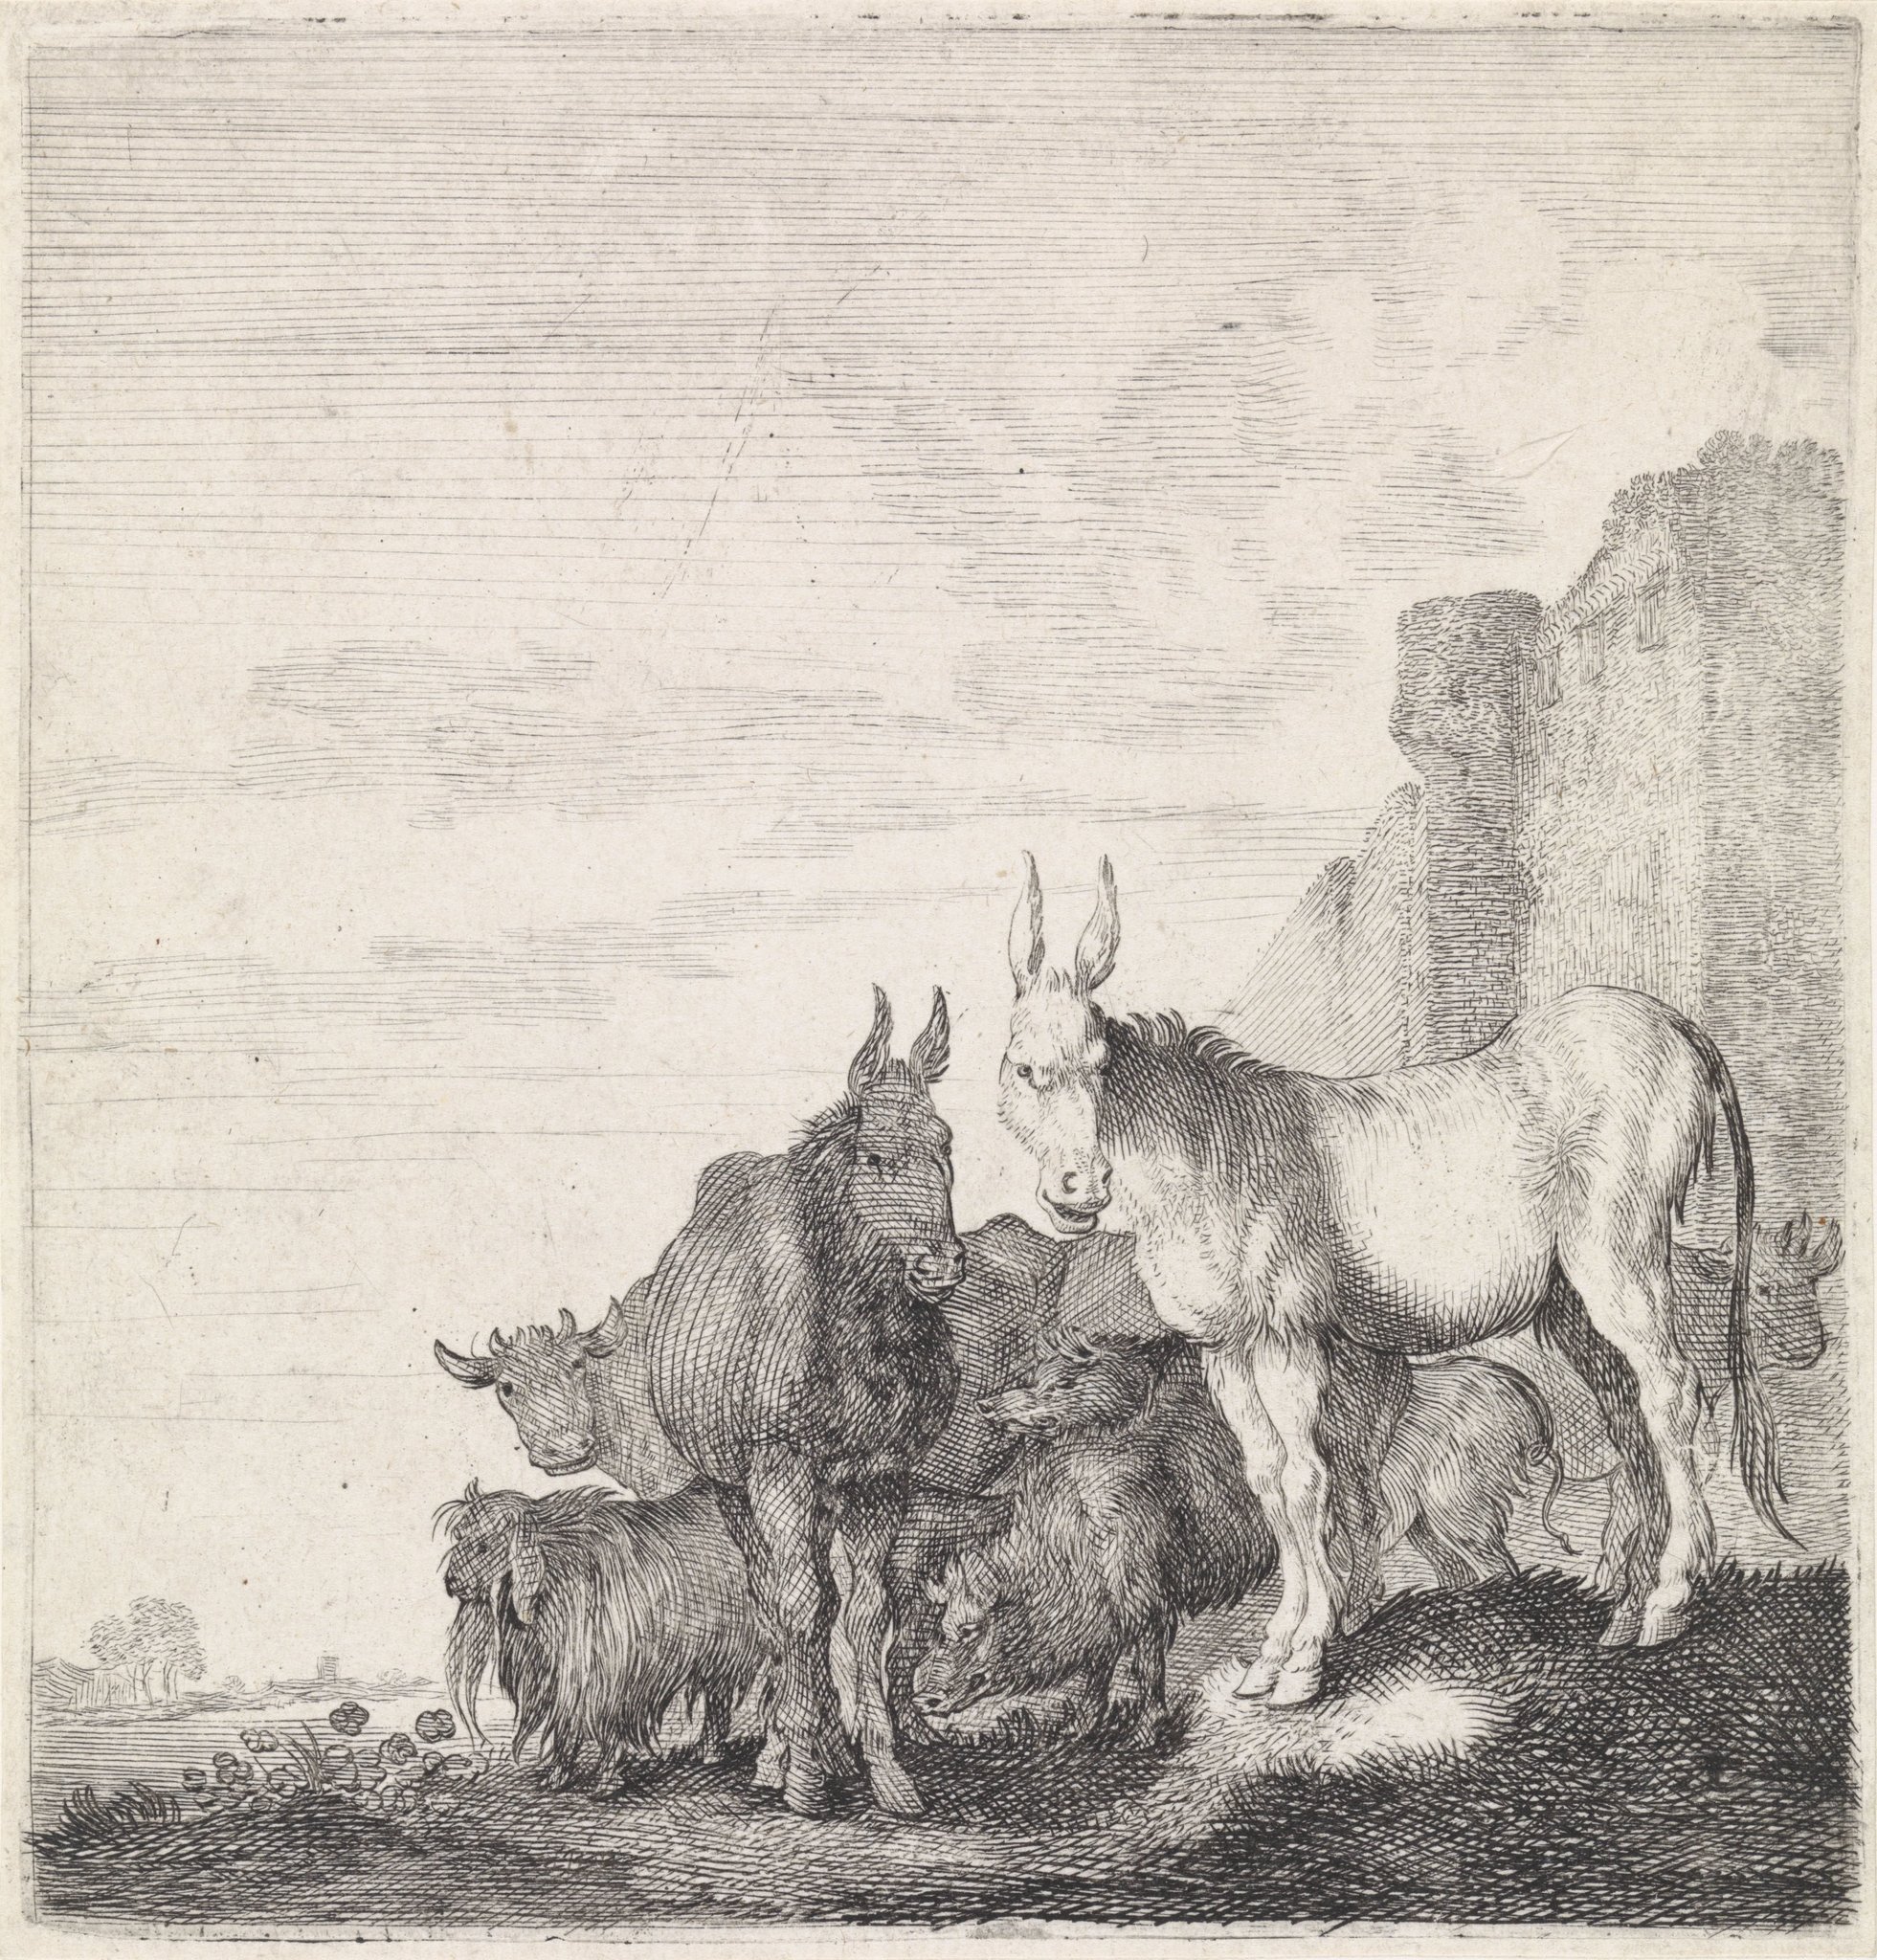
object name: print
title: Ezels bij een muur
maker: moyses van wtenbrouck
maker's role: painter, print maker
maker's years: 1590-1647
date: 1600-1647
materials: paper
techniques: engraving, etching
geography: the hague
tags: bovine cattle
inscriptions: collector's mark: Lugt 240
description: Twee ezels staan bij een hoge (kasteel)muur. Achter de ezels staan zwijnen, koeien en geiten.